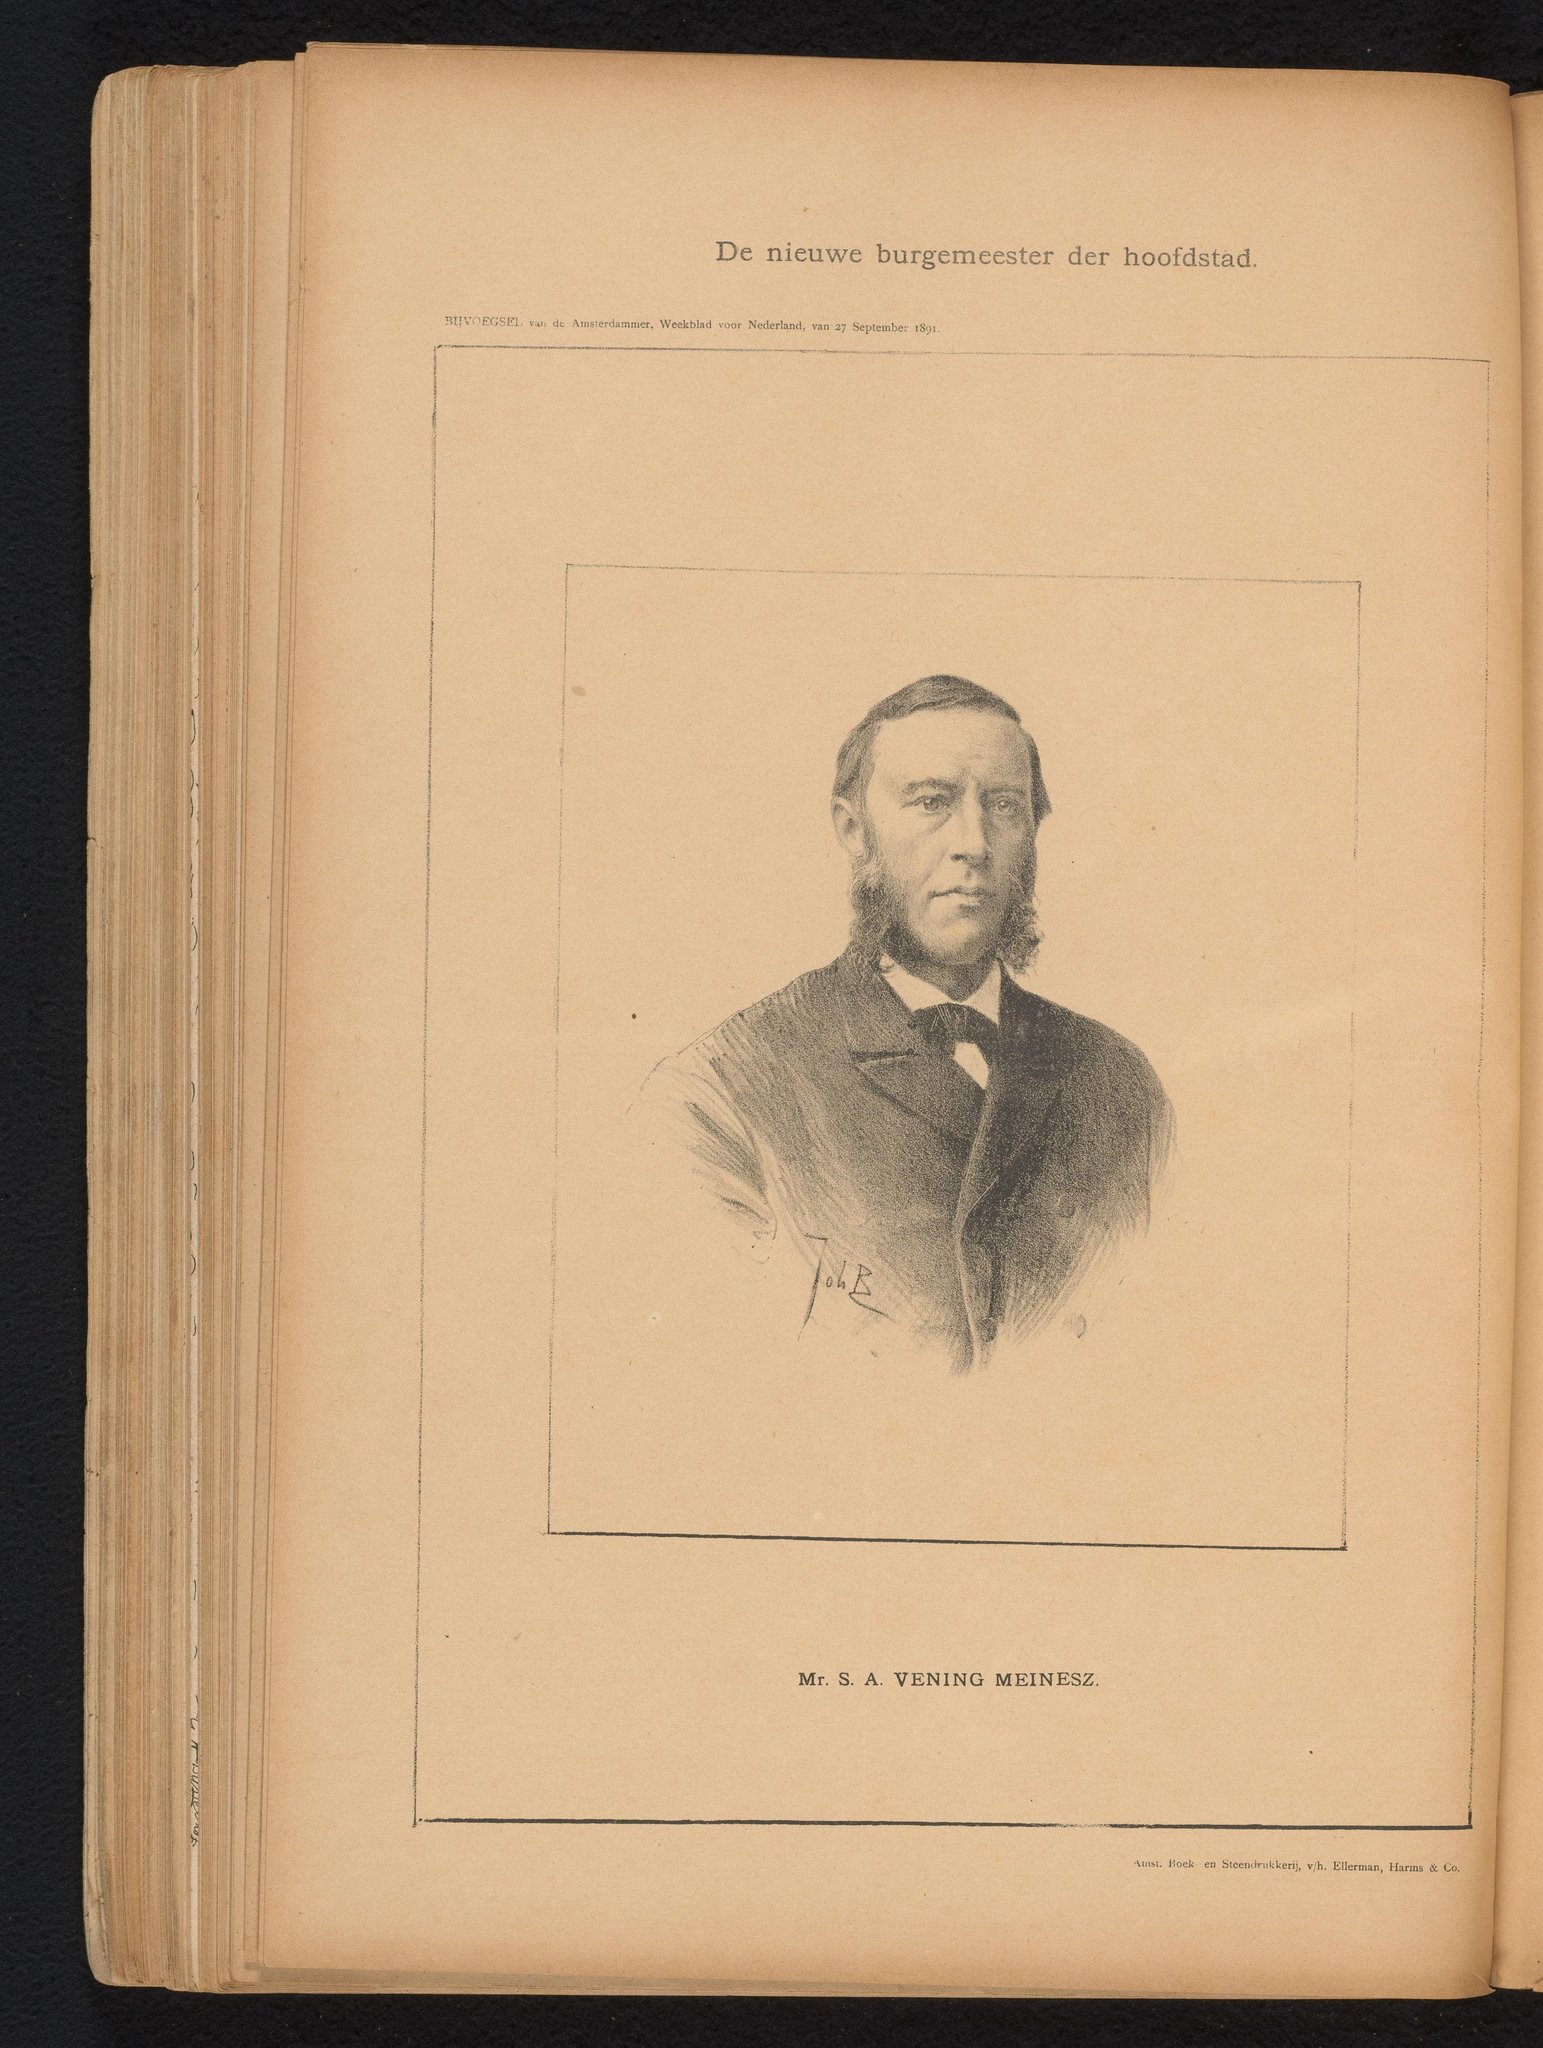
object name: print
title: De nieuwe burgemeester der hoofdstad. / Mr. S.A. Vening Meinesz.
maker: johan braakensiek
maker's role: draughtsman, print maker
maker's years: 1858-1940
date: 1891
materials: paper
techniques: lithograph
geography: netherlands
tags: mayor, burgomaster, historical persons, amsterdam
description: Portret van nieuwe burgemeester van Amsterdam, Sjoerd Anne Vening Meinesz.